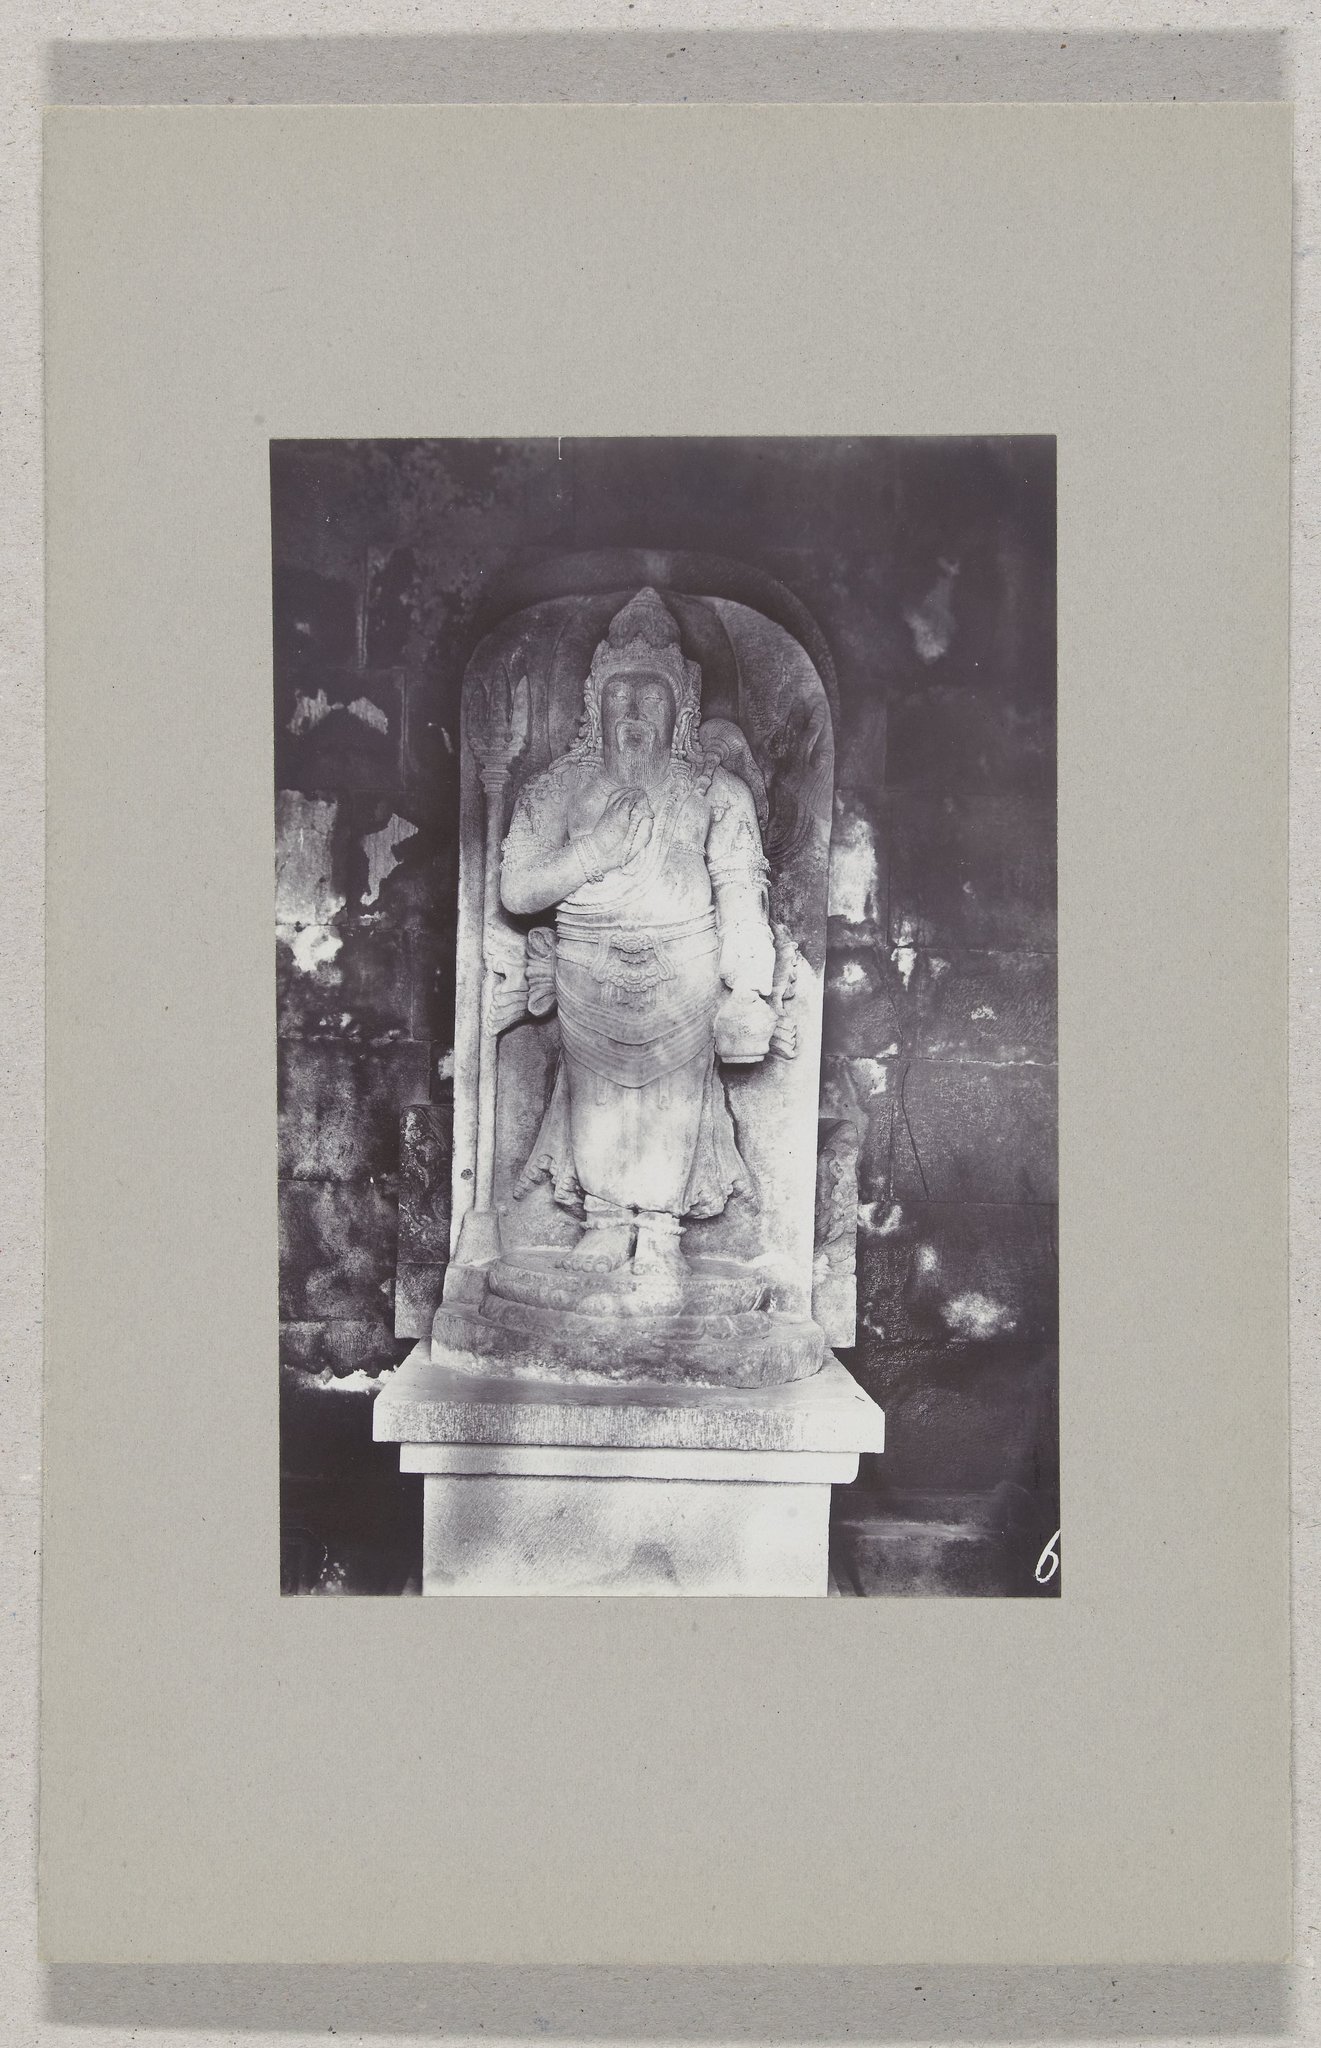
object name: photograph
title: 86a Beeld in zijnis tempel a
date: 1895-1915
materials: cardboard, paper, photographic support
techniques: gelatin silver print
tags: indonesia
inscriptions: number: ‘6’, annotation: ‘86a Beeld in zijnis tempel a’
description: Beeld in een zijnis van een tempel van Prambanan bij Jogyakarta, Nederlands-Indië